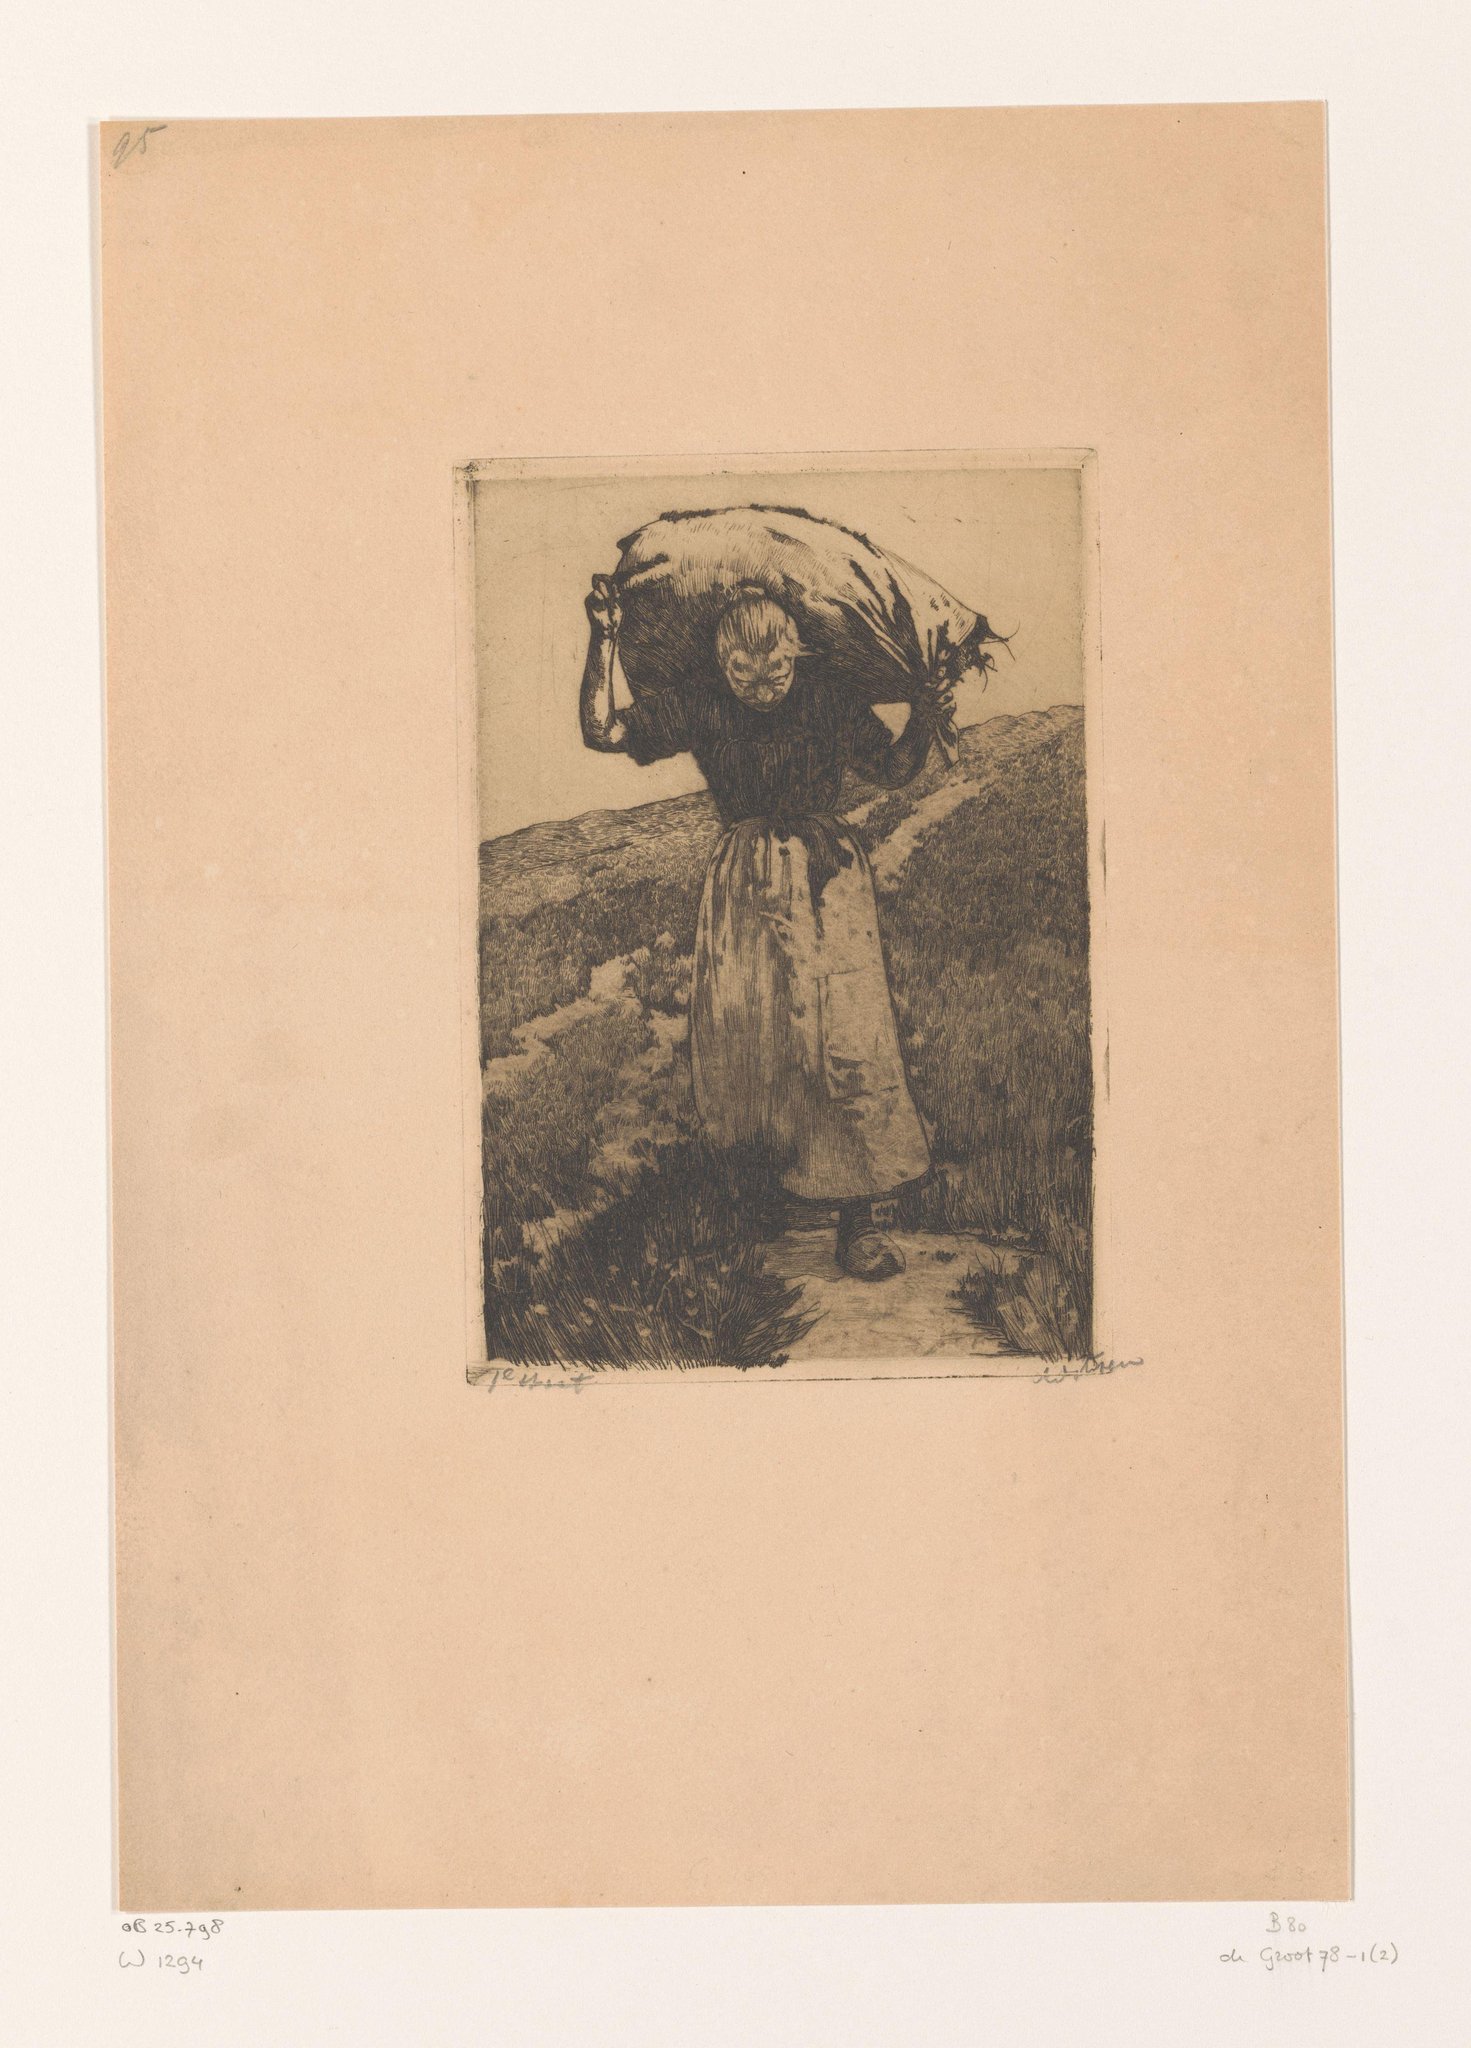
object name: print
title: Op de heide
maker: willem witsen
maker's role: draughtsman, painter, print maker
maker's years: 1860-1923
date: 1897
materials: paper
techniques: etching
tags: farmers - aa - female farmer, farmer's wife, storing in sacks ~ harvest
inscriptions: annotation: ‘1e staat’